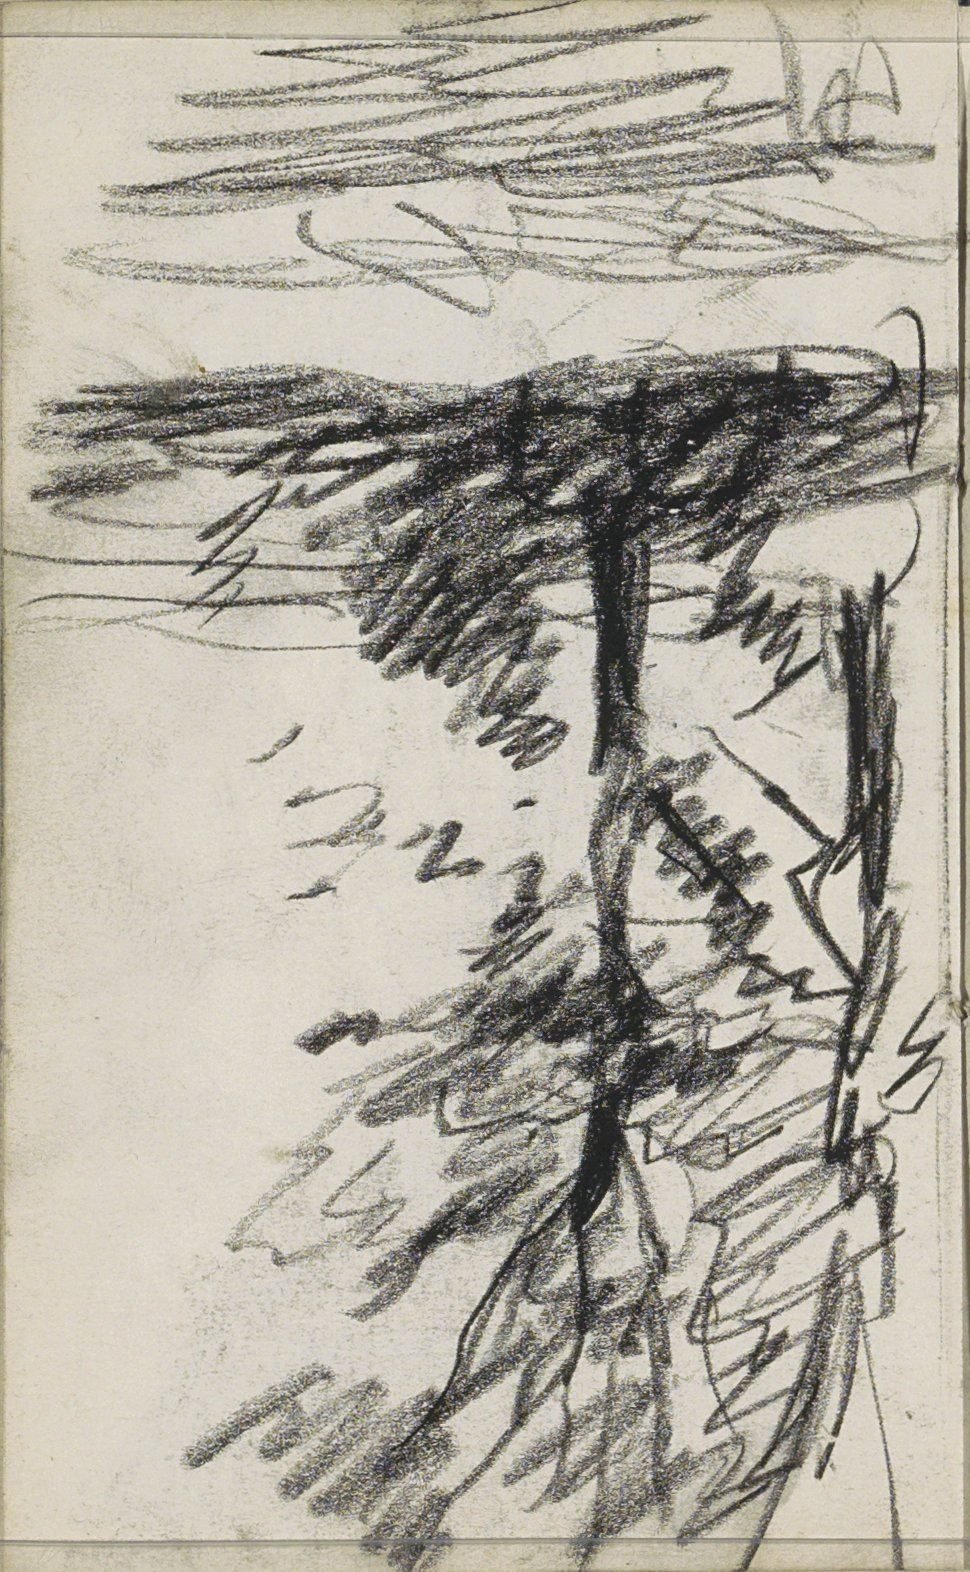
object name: sketchbook leaf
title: Bomen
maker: anton mauve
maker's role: draughtsman, painter, print maker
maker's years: 1838-1888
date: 1848-1888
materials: chalk, paper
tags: trees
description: Blad 27 verso uit een schetsboek met 53 bladen.